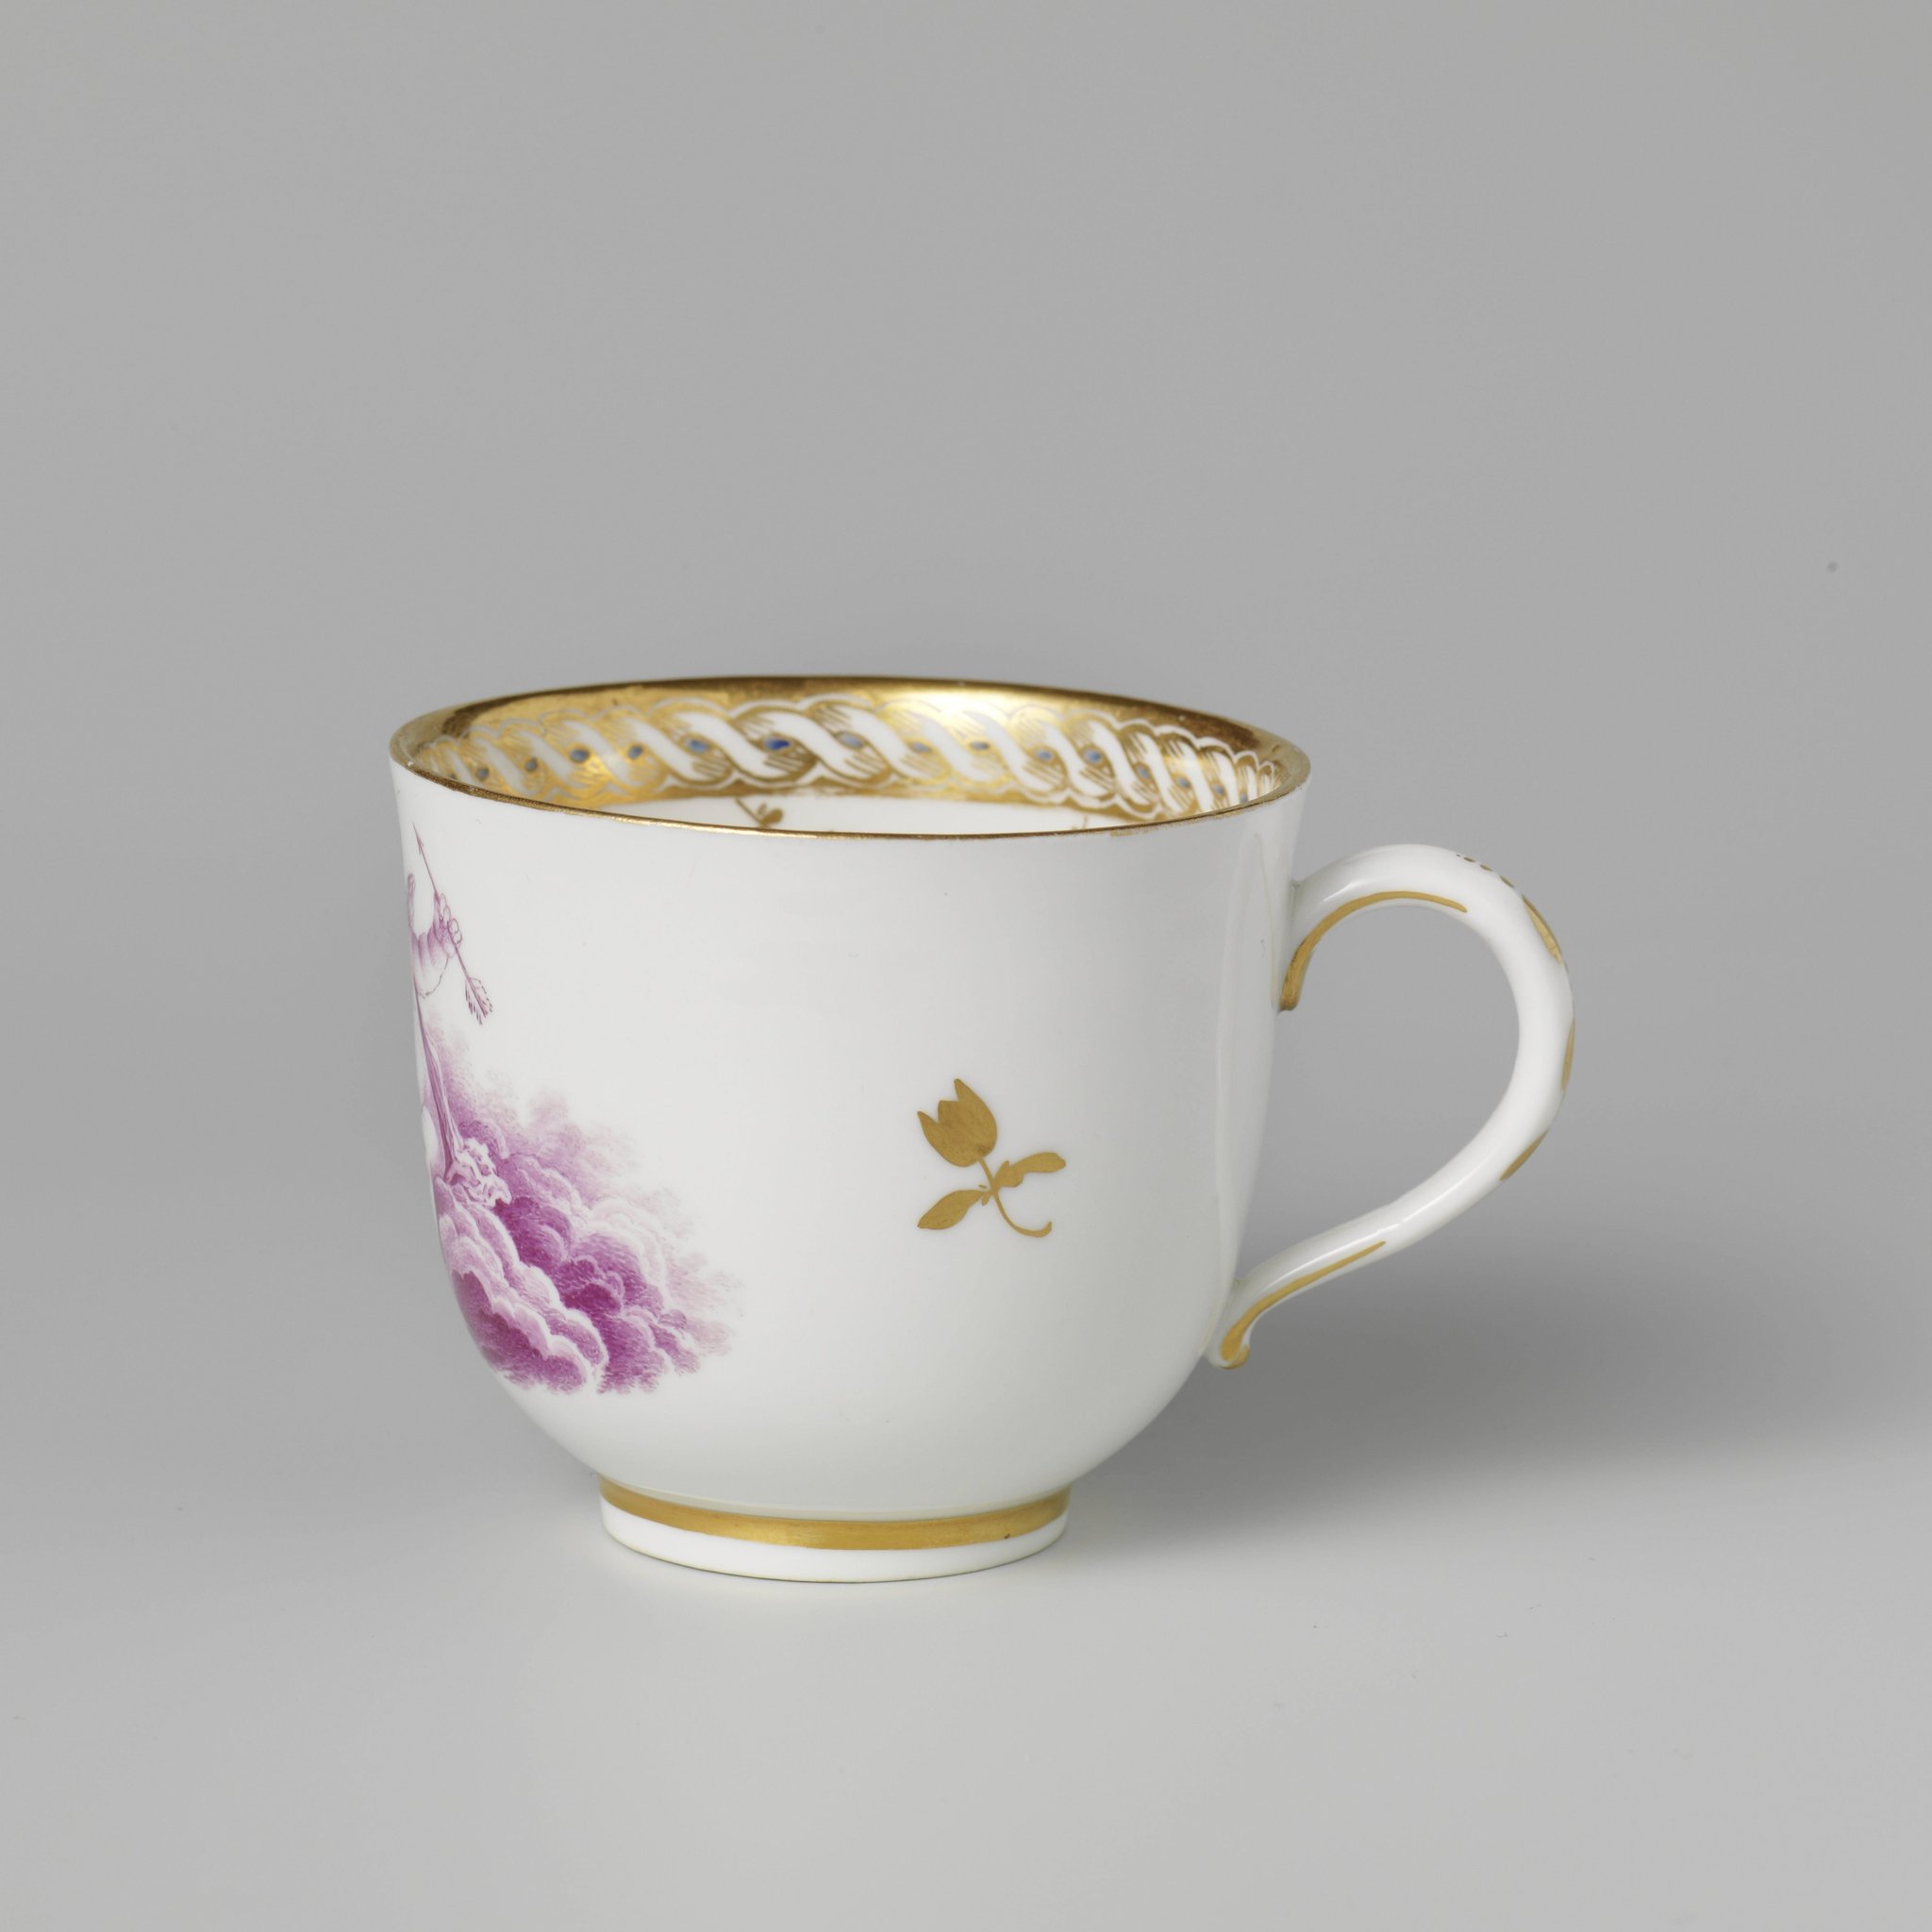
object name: service set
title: Cup with a putto on clouds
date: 1785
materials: glaze, gold, paint, porcelain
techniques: firing, forming, gilding, turning, vitrification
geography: germany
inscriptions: mark: ‘ooievaar’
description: Kop (koffiekop) van porselein met een C-vormig oor, beschilderd op het glazuur in roze (camaïeu) en goud. Op de buitenwand een putto met een pijl en boog en een vogel op een wolk. Om de voorstelling strooibloemen in goud. De binnenrand met een gedraaide band, waaraan guirlandes en bloemtakken hangen. Gouden lijn op de voet en gouden rand. Gemerkt op de onderzijde met de ooievaar.